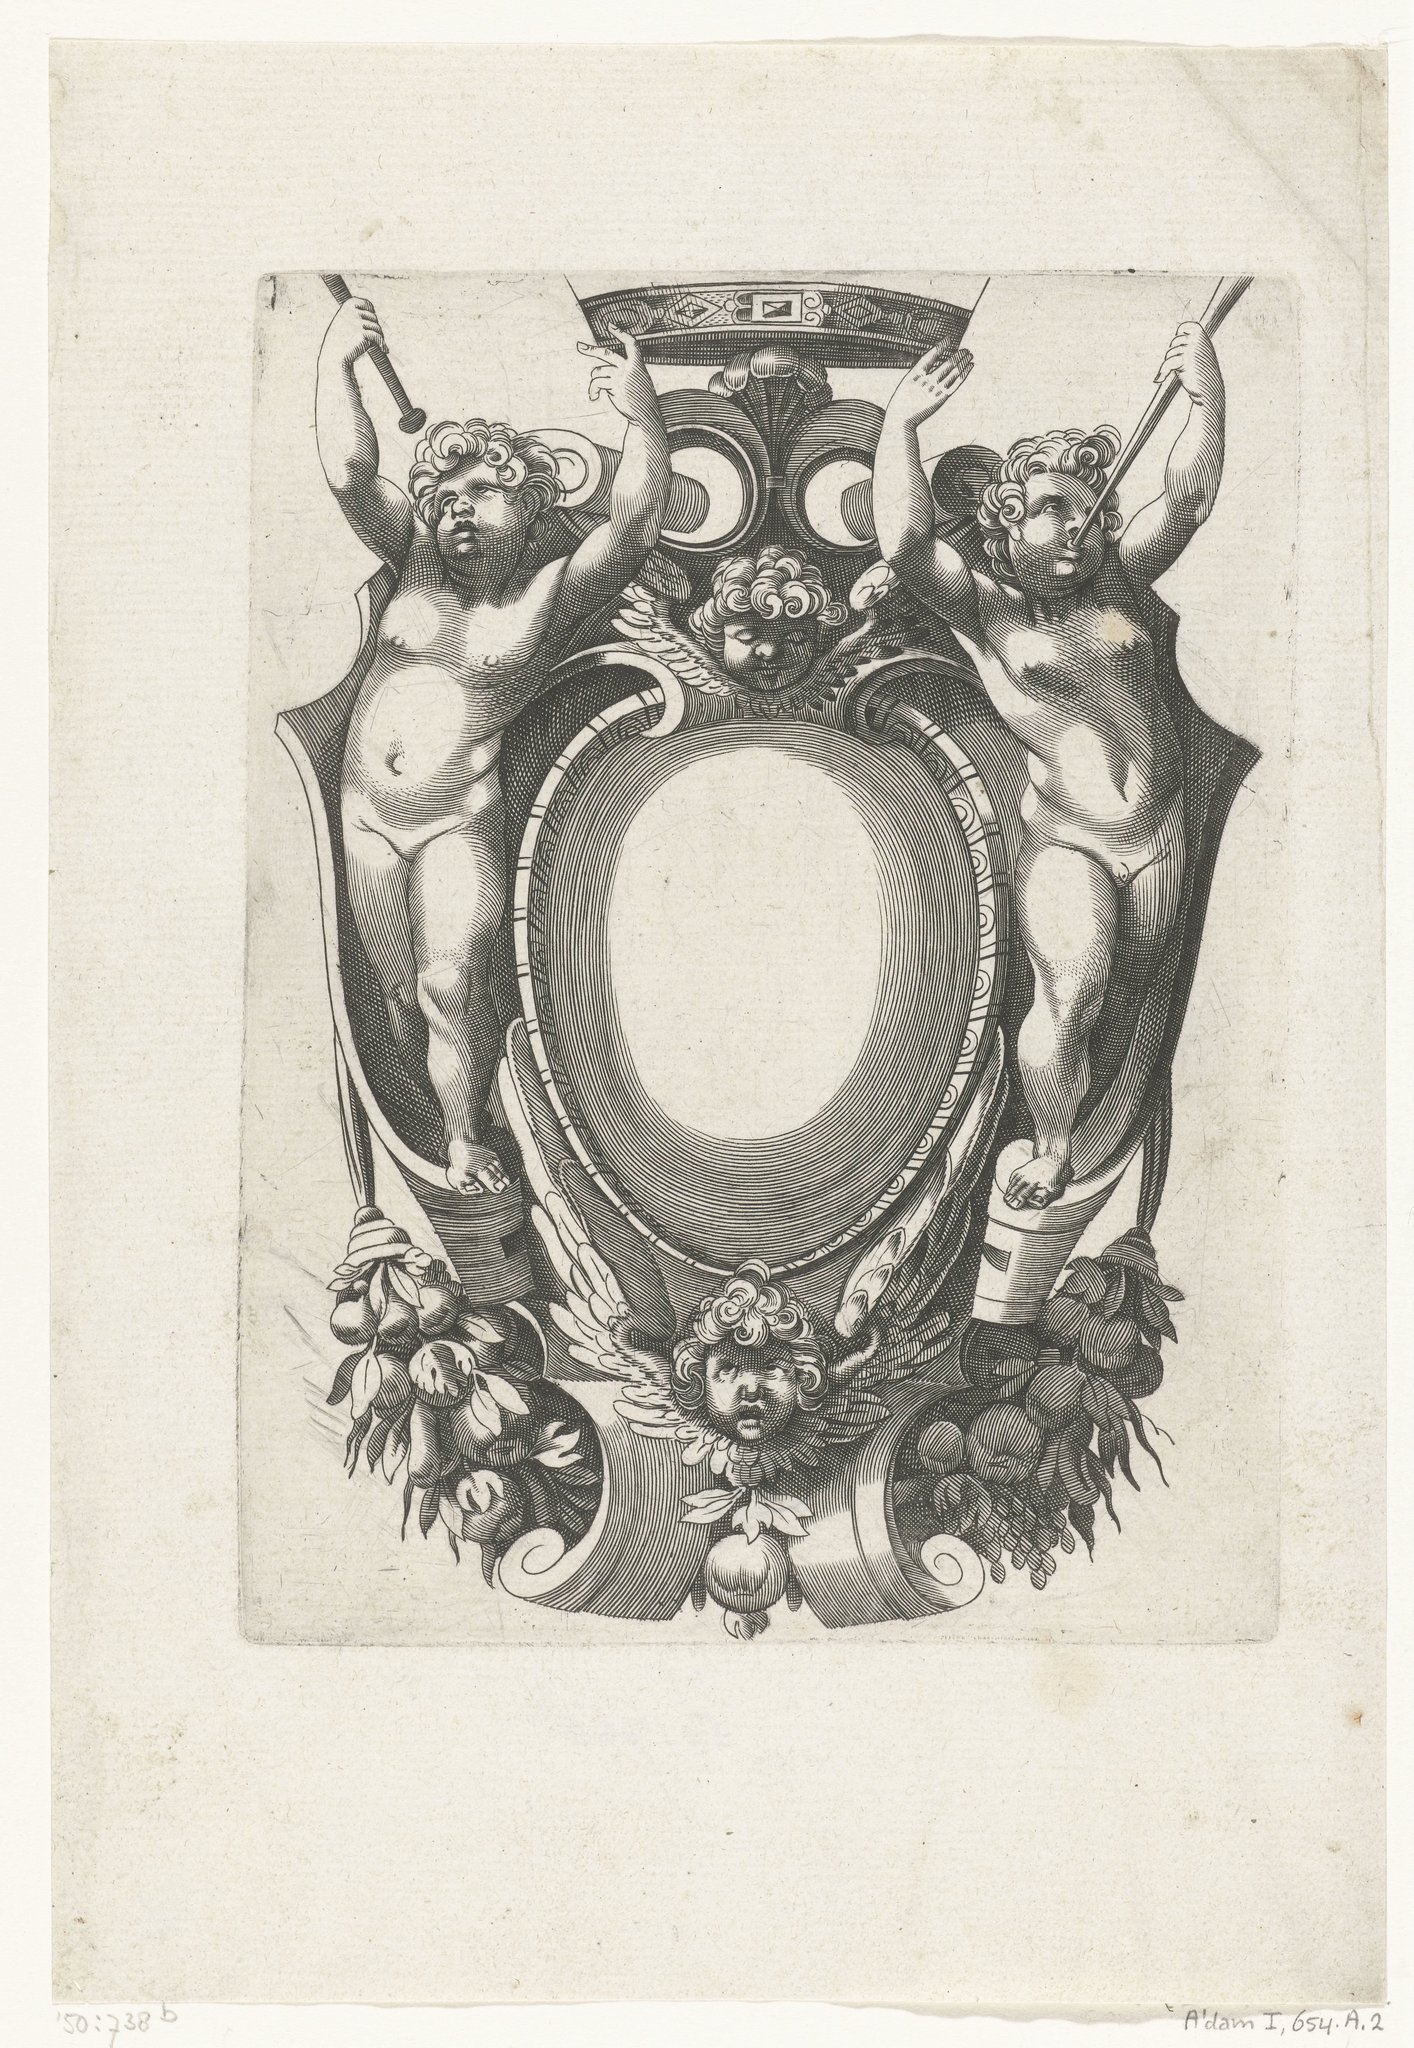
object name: print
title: Cartouche geflankeerd door twee kinderen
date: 1628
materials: paper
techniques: engraving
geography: france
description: De kinderen houden met hun ene hand een baldakijn hoog en dragen in hun andere een blaasinstrument.